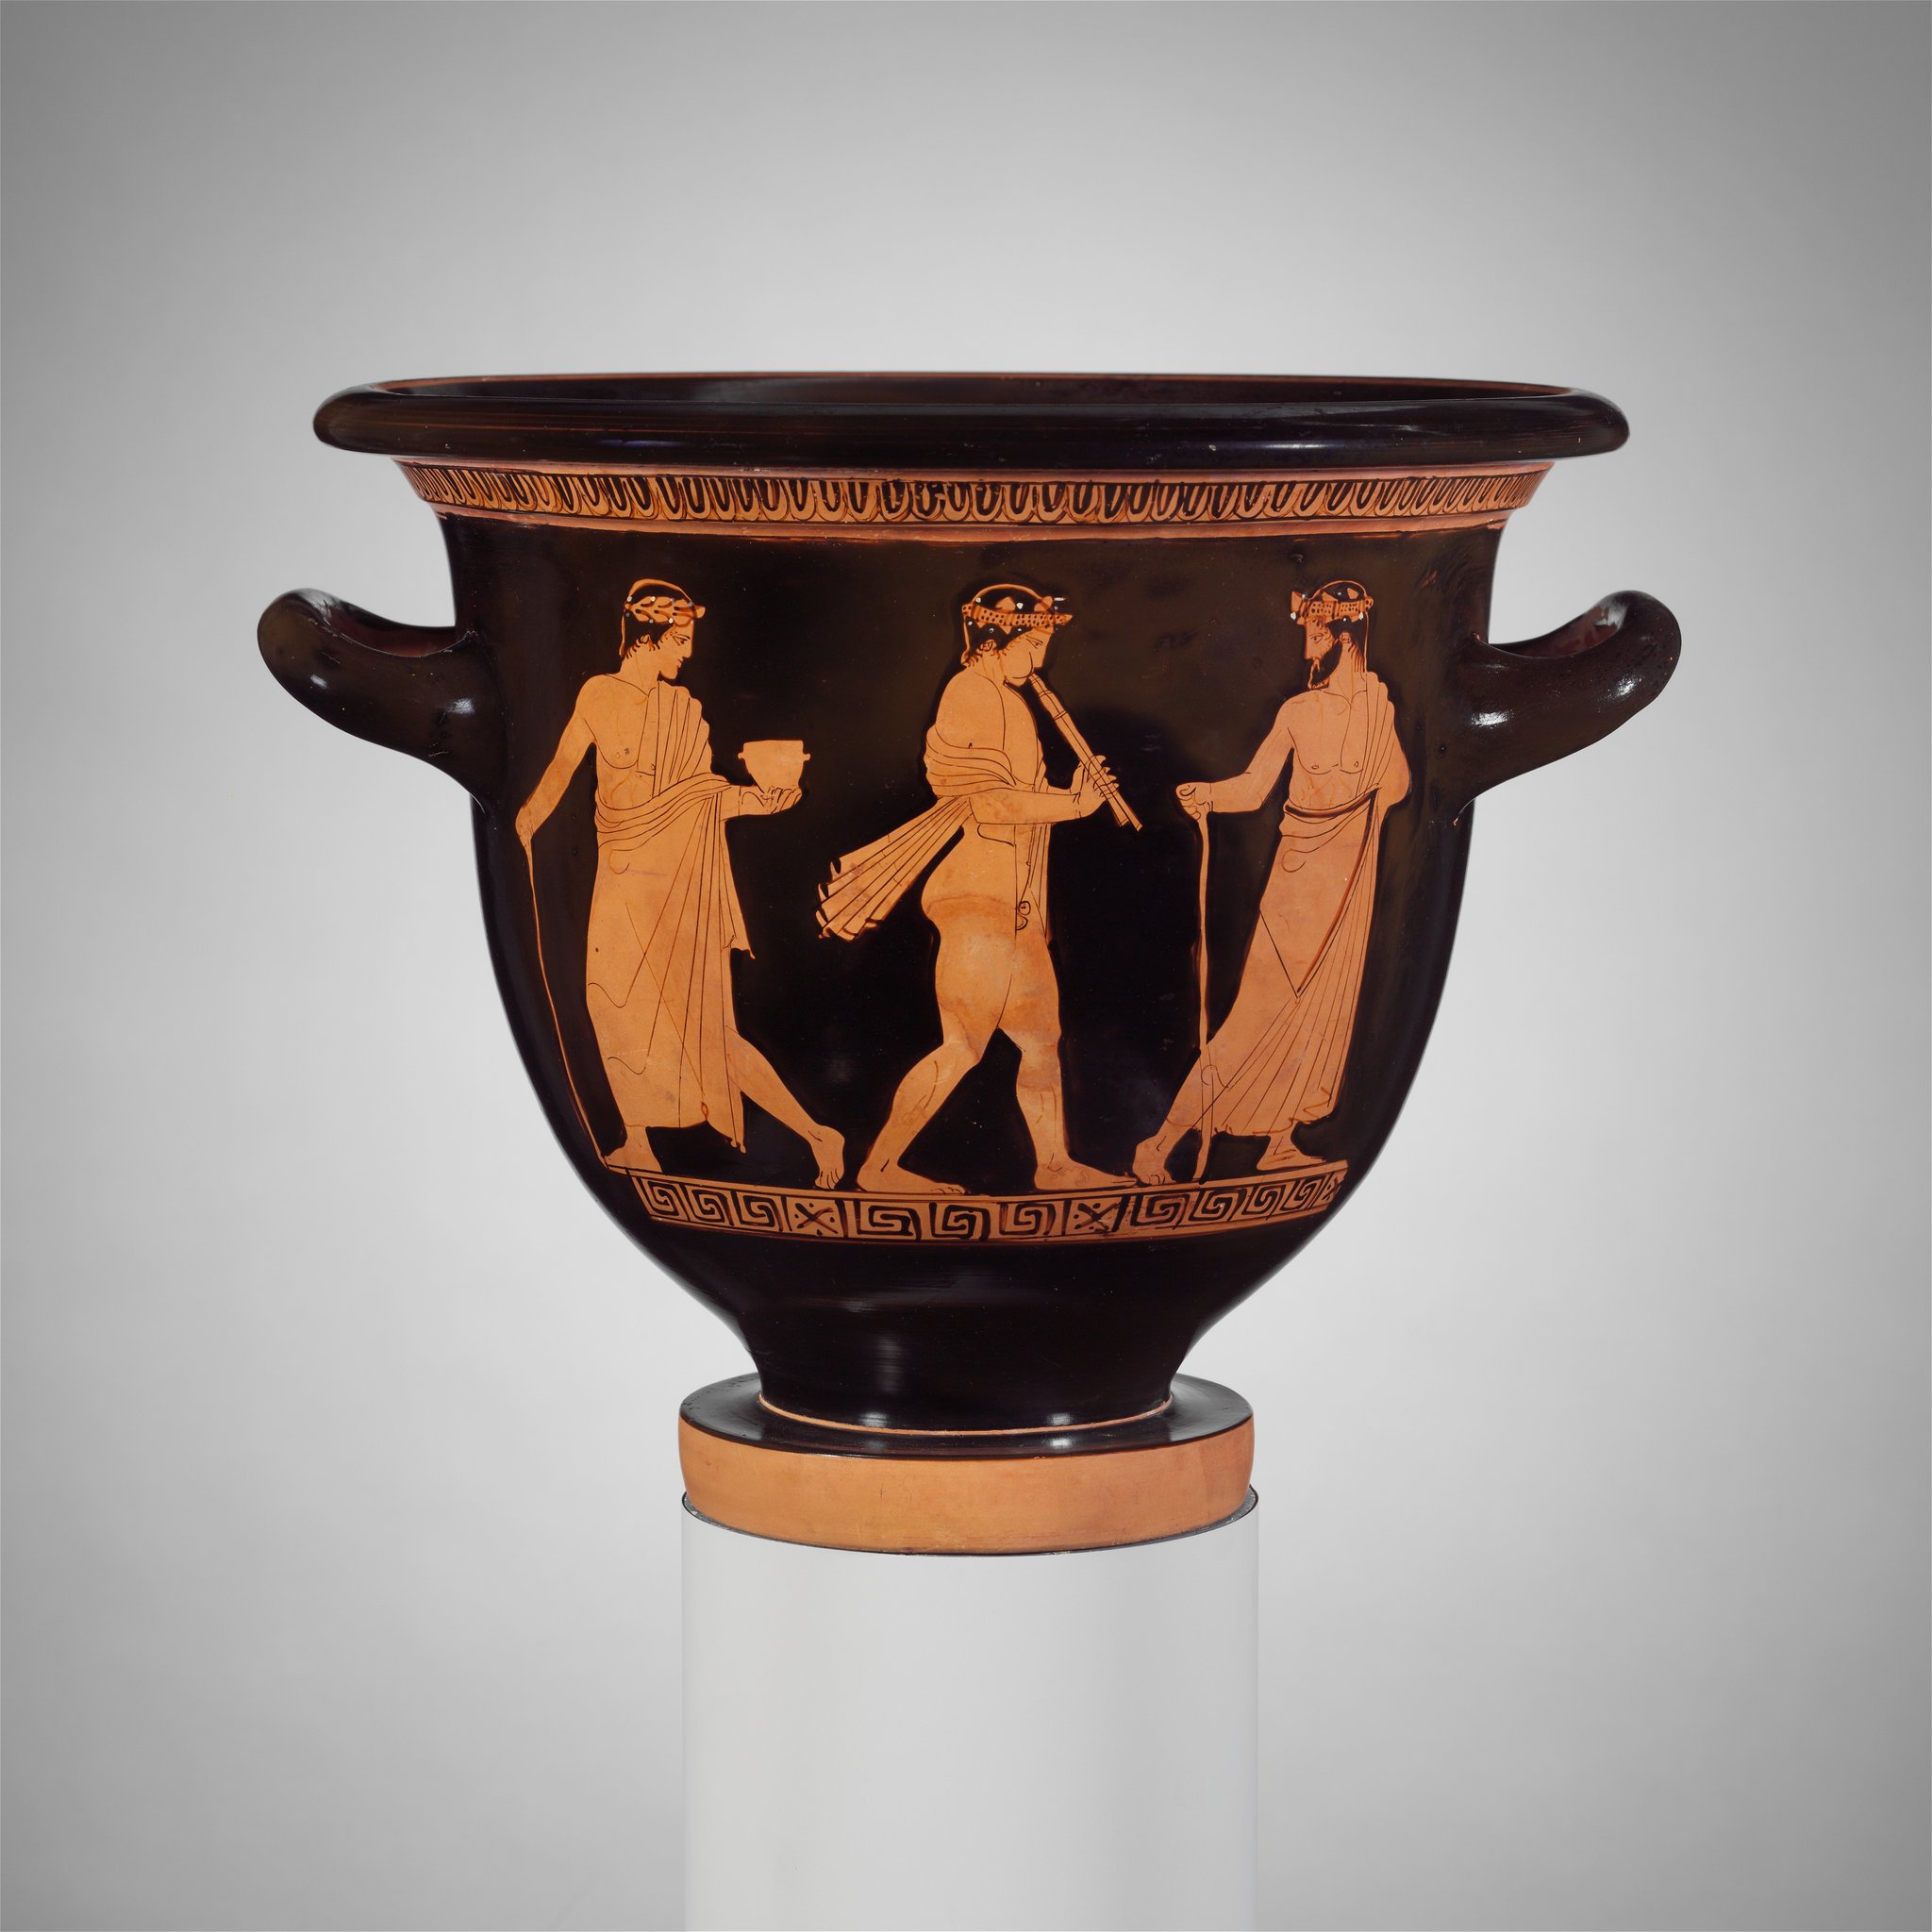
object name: bell krater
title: Terracotta bell-krater (bowl for mixing wine and water)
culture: greek, attic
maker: menelaos painter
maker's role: artist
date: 440 BCE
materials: terracotta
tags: men,male nudes,flutes